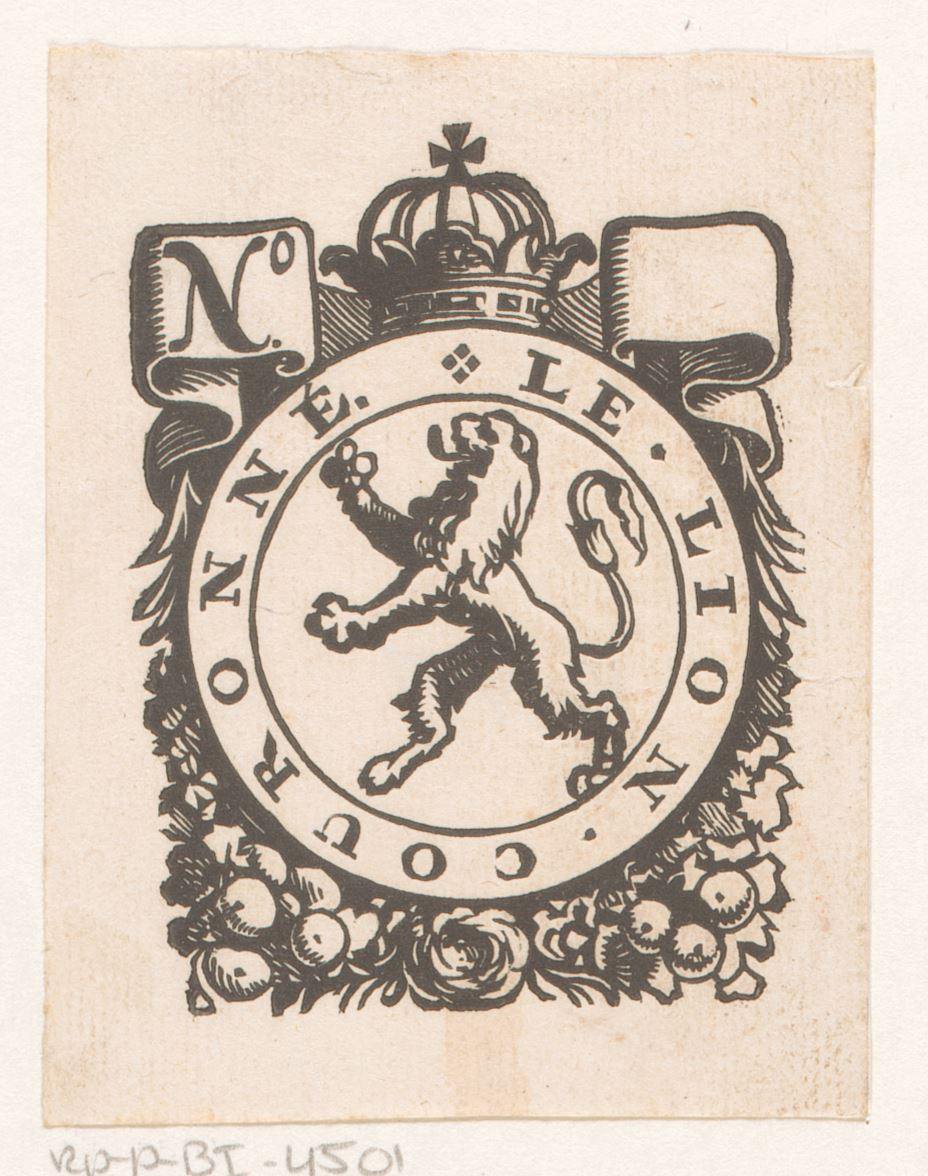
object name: print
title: Vignet met een leeuw en een kroon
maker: Anonymous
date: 1600-1699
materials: paper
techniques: woodcut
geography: netherlands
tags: crown (symbol of sovereignty), beasts of prey, predatory animals: lion, vignette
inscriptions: collector's mark: Lugt 240